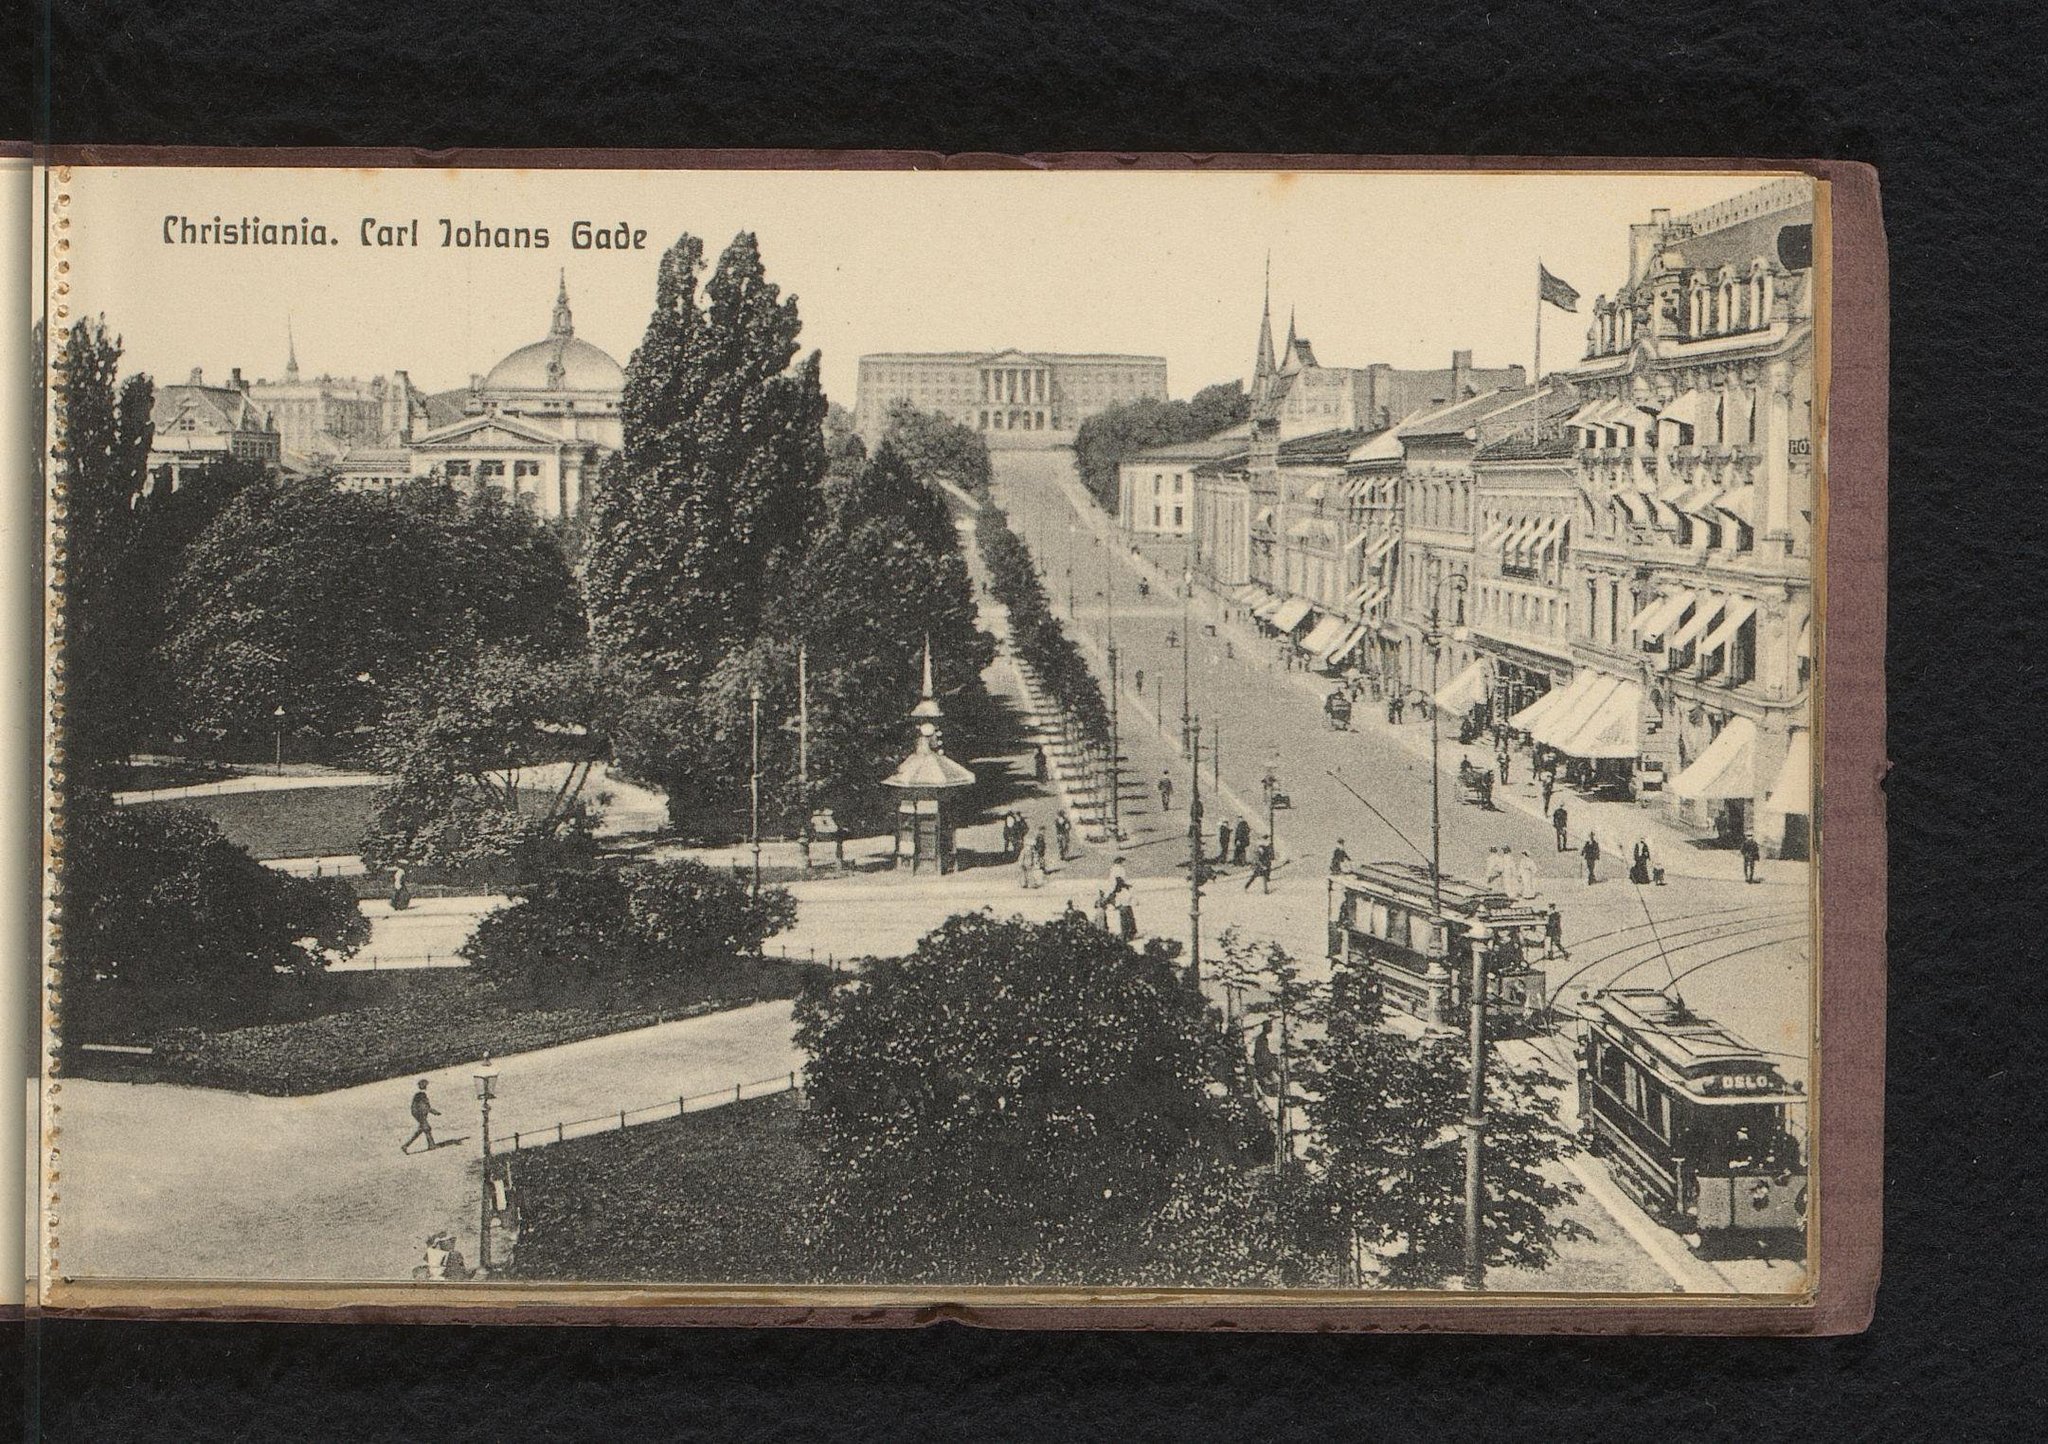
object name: ansichtkaart, prentbriefkaart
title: Christiania. Carl Johans Gade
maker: Anonymous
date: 1904-1925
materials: cardboard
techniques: photograph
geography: oslo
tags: tram, palace, avenue, boulevard, promenade, esplanade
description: Prentbriefkaart maakt deel uit van een album.